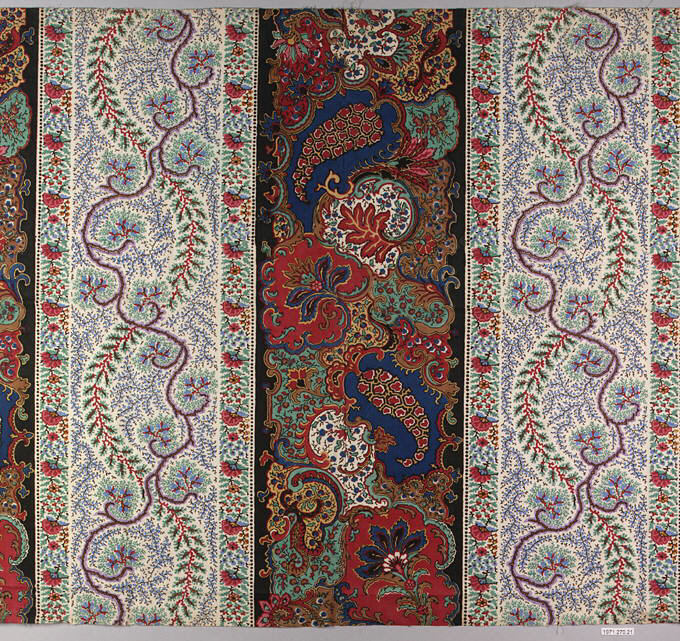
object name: piece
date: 1835-1855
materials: cotton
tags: flowers,leaves